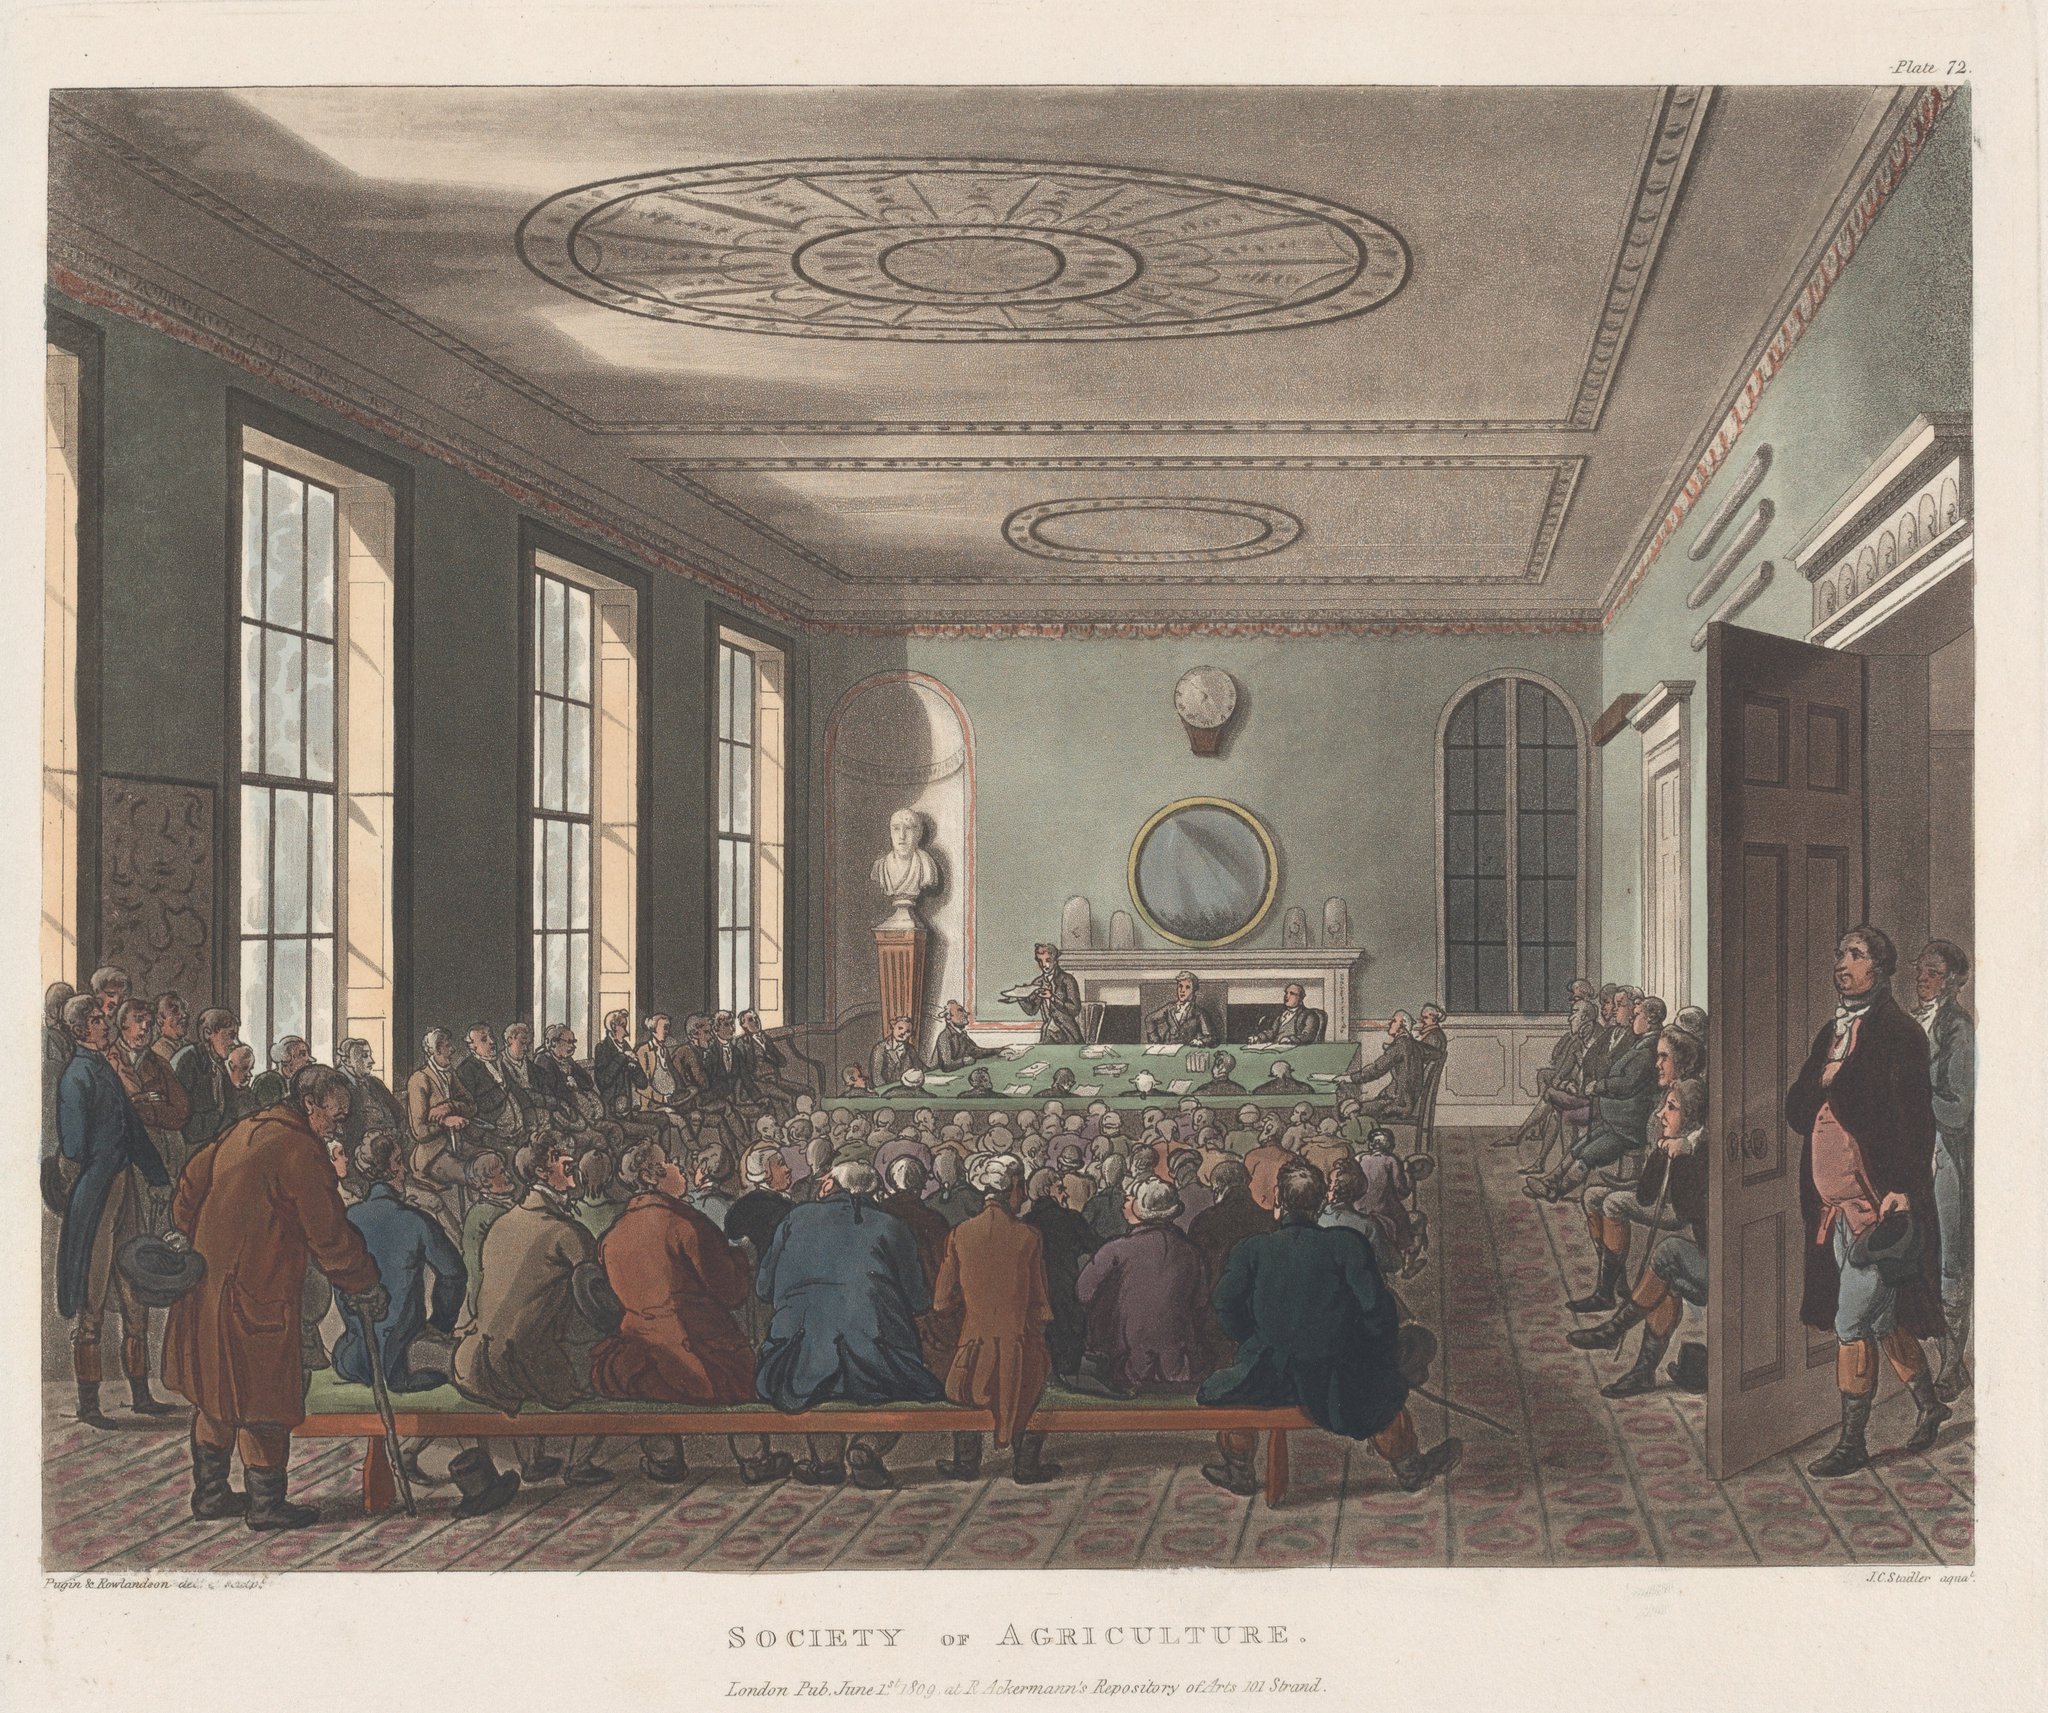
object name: print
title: Society of Agriculture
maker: thomas rowlandson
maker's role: artist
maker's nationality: british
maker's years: 1757-1827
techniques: aquatint, etching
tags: interiors,men